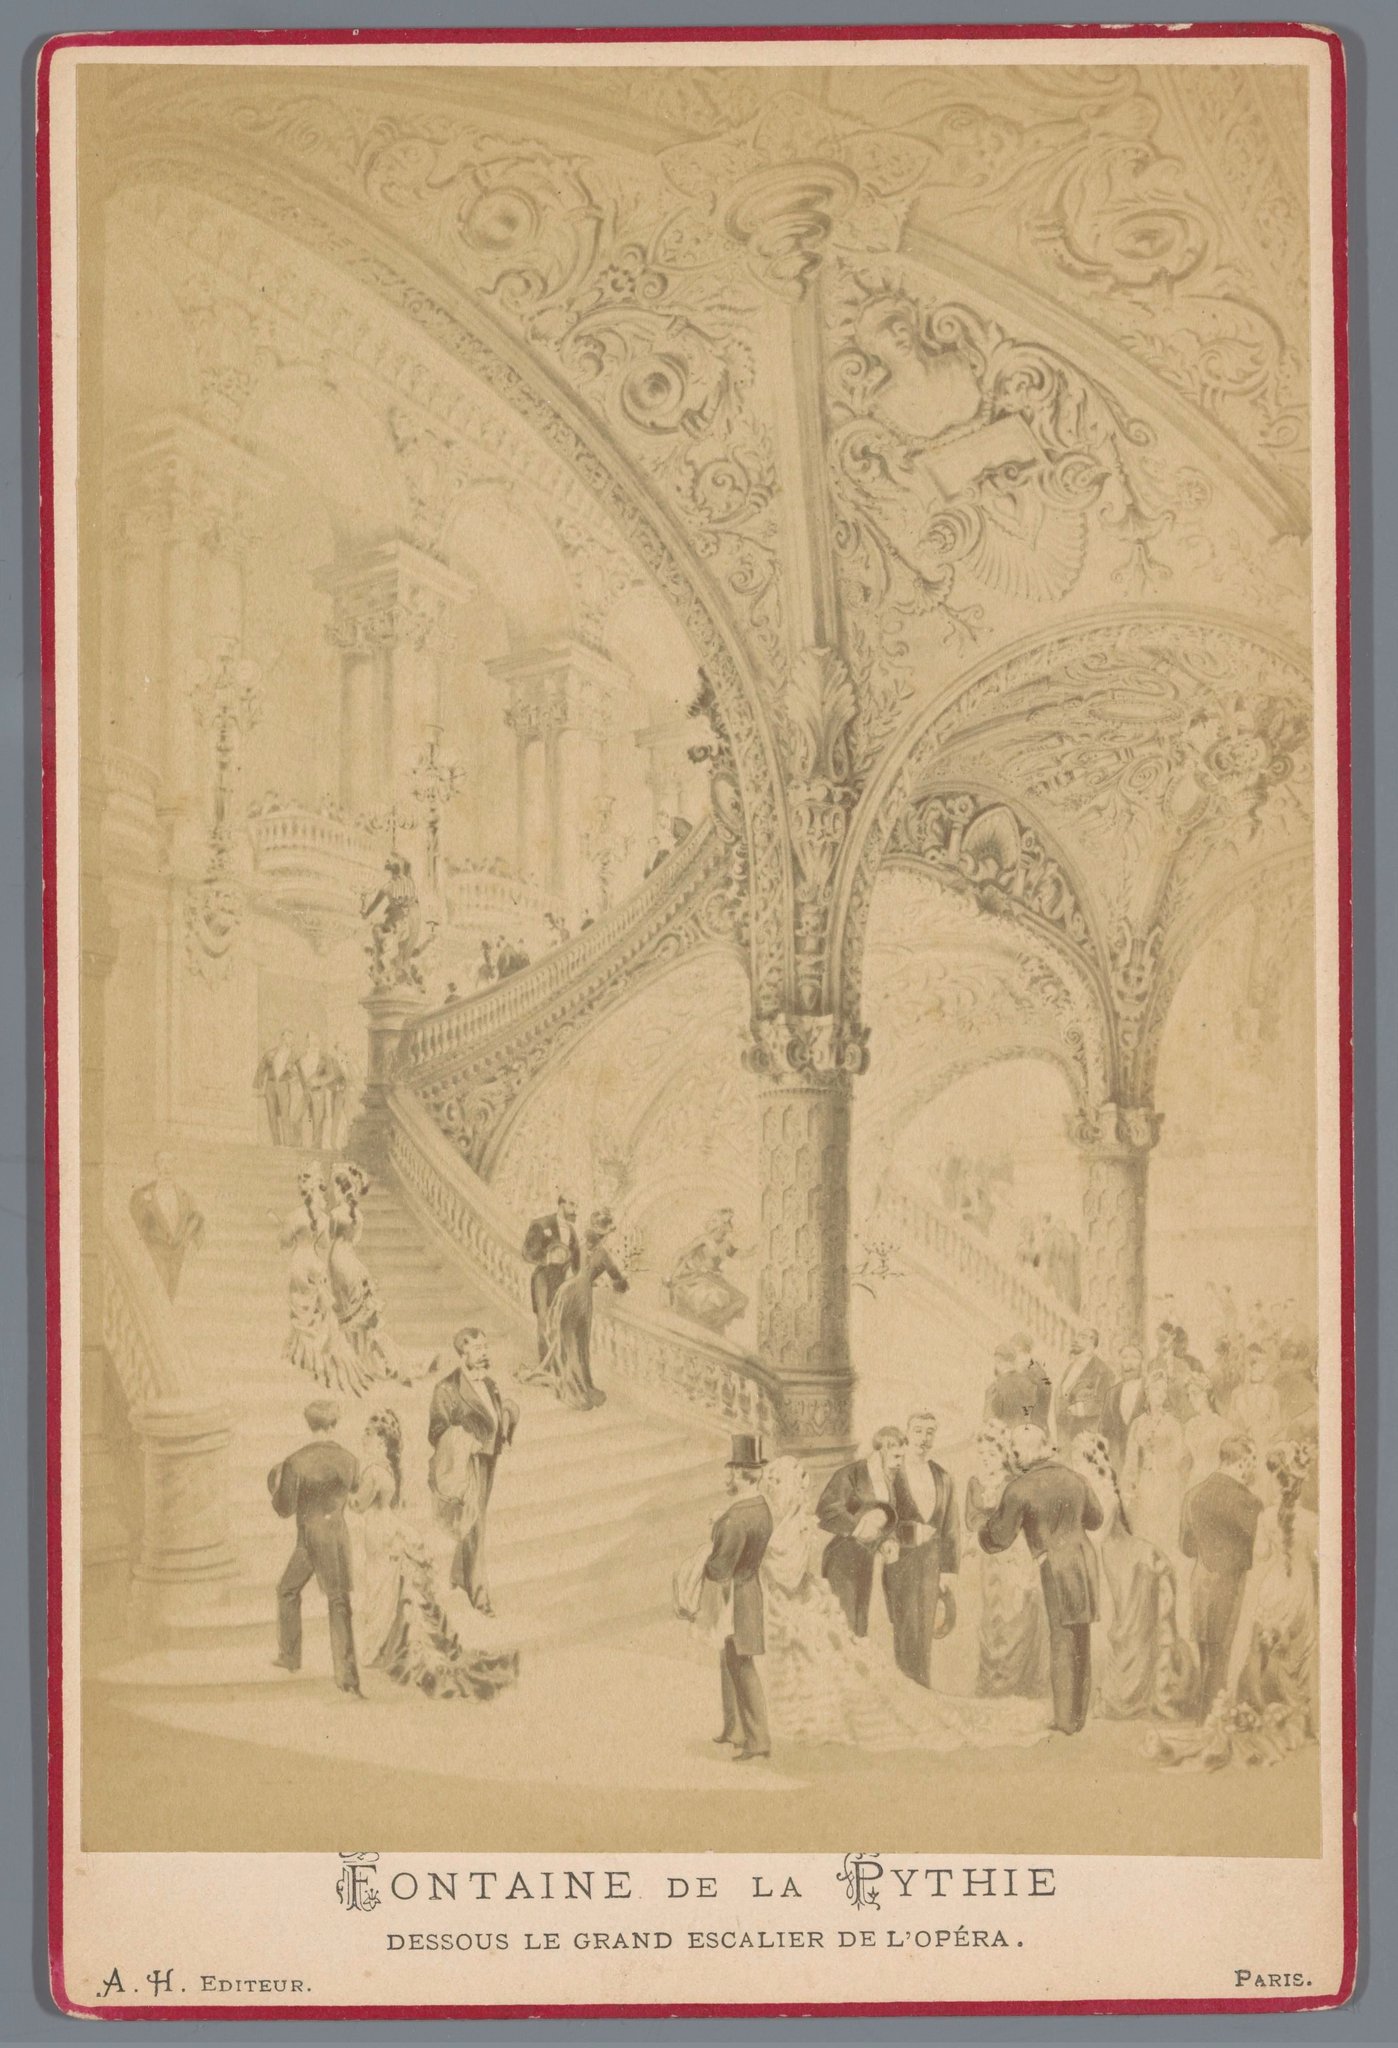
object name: reproduction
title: Fontaine de la Pythie, dessous le grand escalier de l'Opéra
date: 1865-1875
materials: cardboard, photographic support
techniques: albumen print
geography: paris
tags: opera house